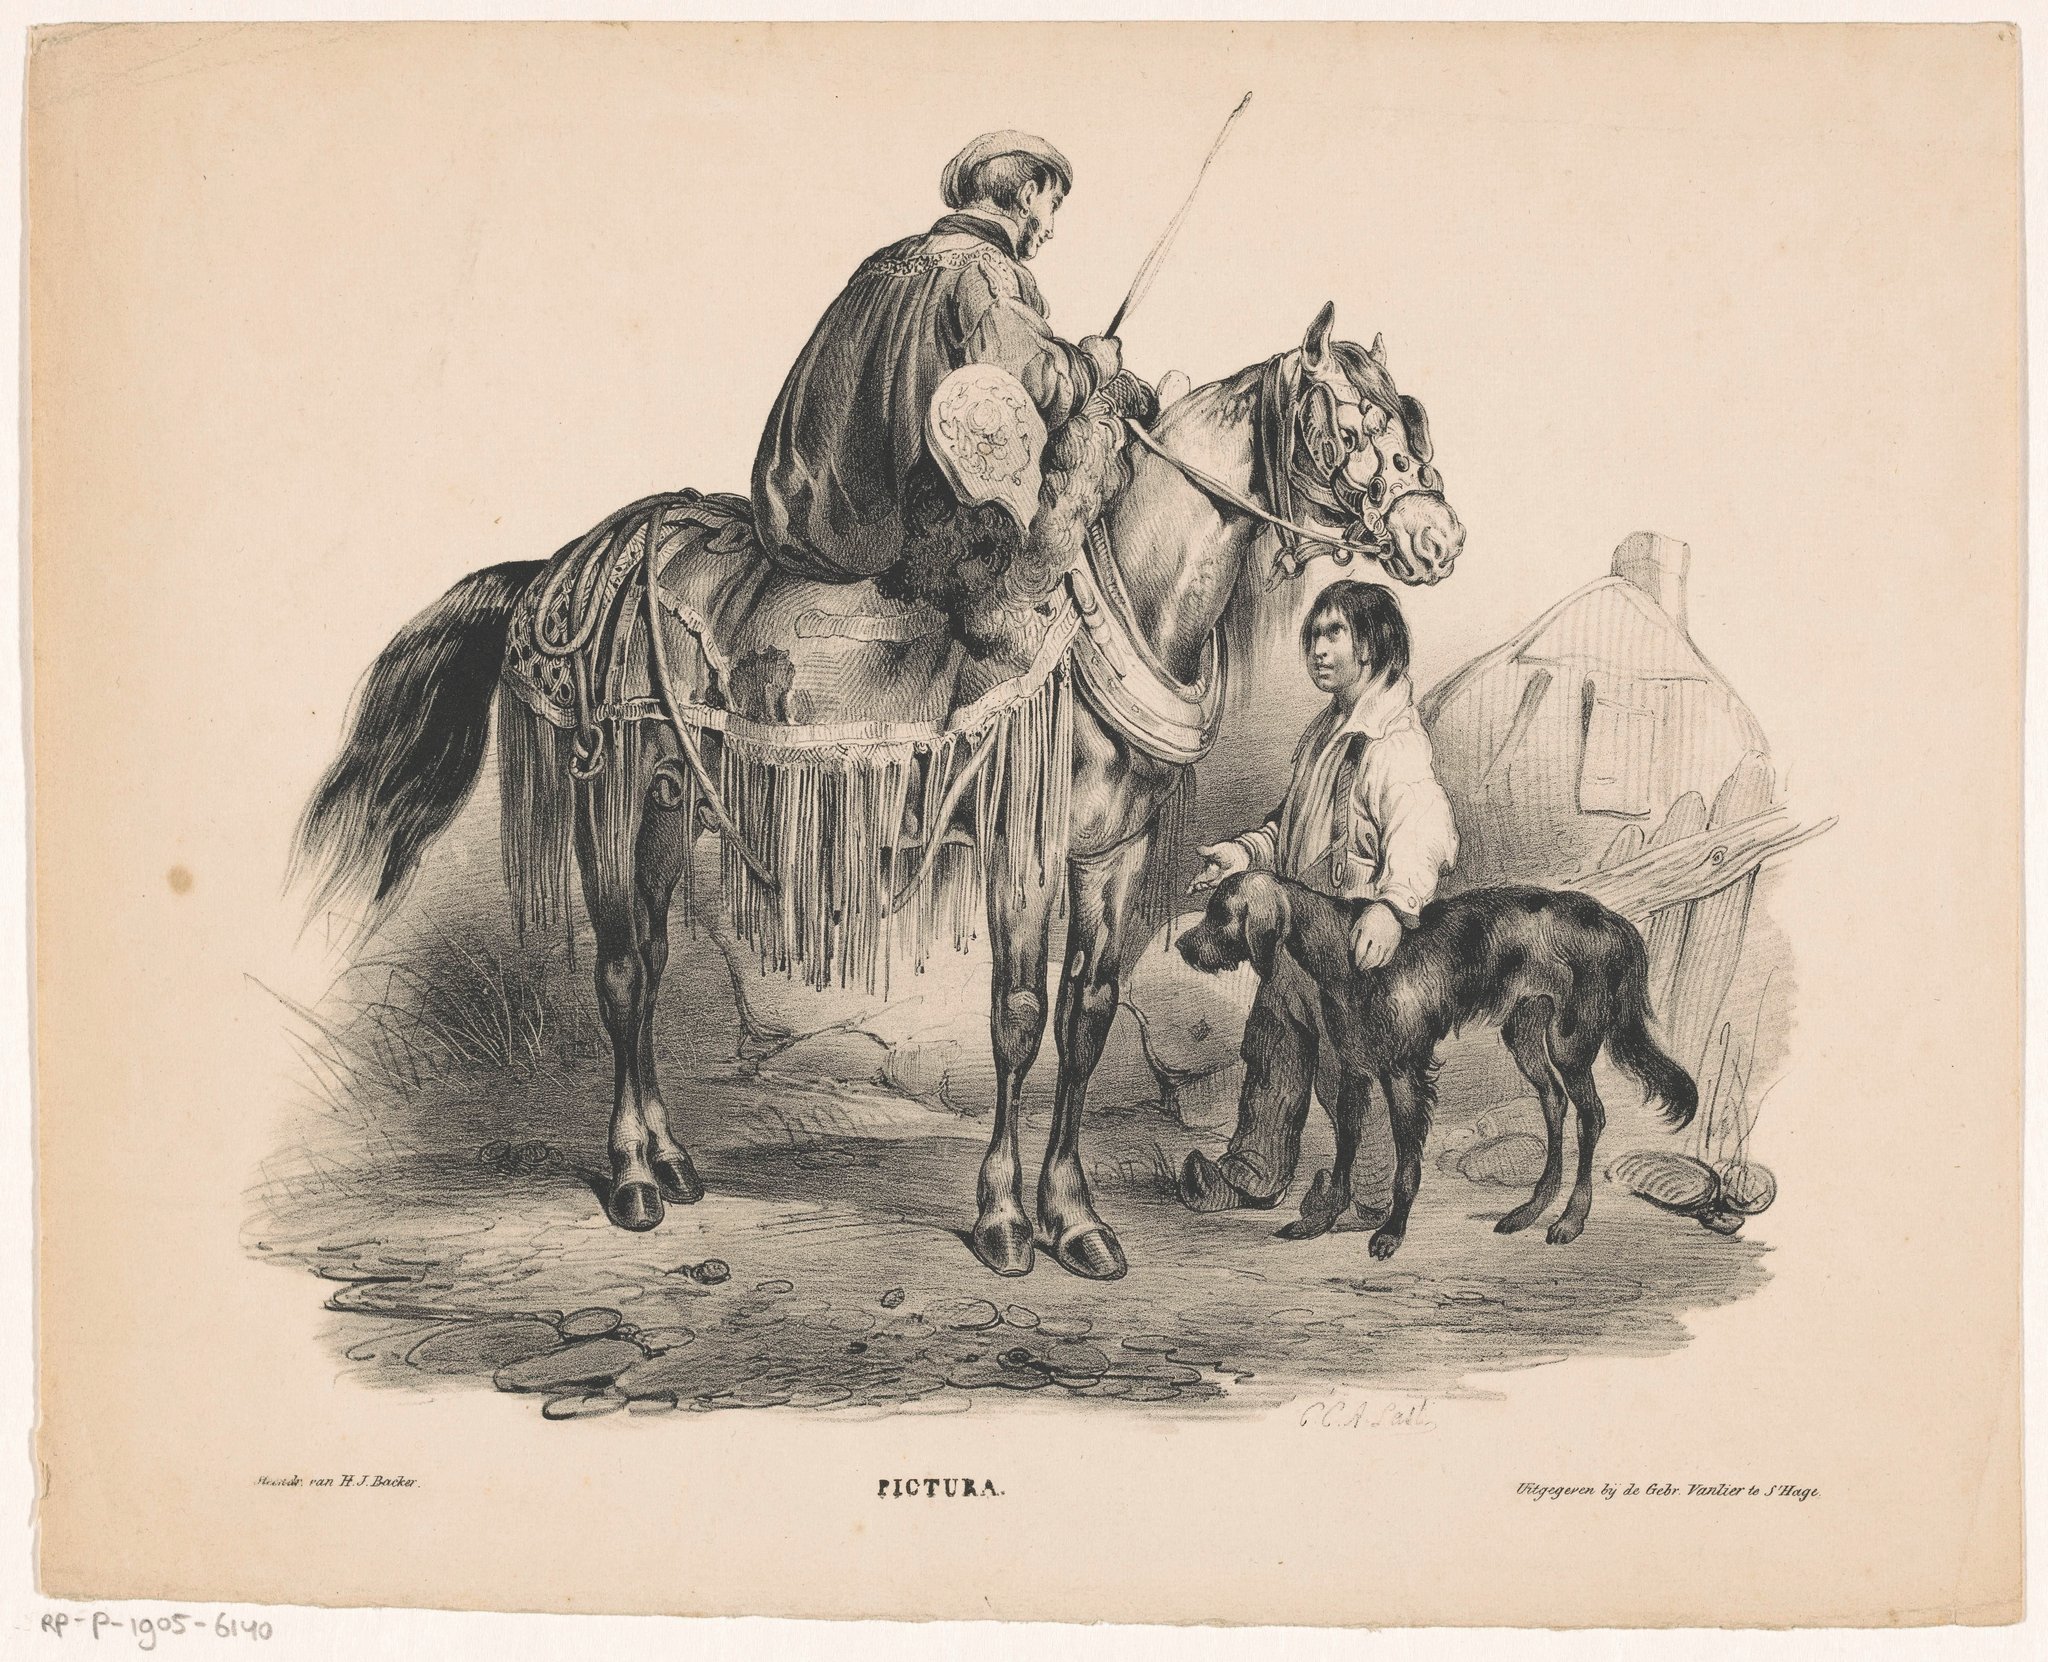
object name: print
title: Edelman te paard en bedelende jongen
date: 1834-1845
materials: paper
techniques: lithograph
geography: dordrecht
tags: riding a horse, ass, or mule; rider, horseman, beggar, dog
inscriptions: watermark: ‘&Z’, collector's mark: Lugt 2228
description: De edelman zit schuin op zijn paard en kijkt naar de jongen met zijn hond. Deze houdt zijn hand omhoog.